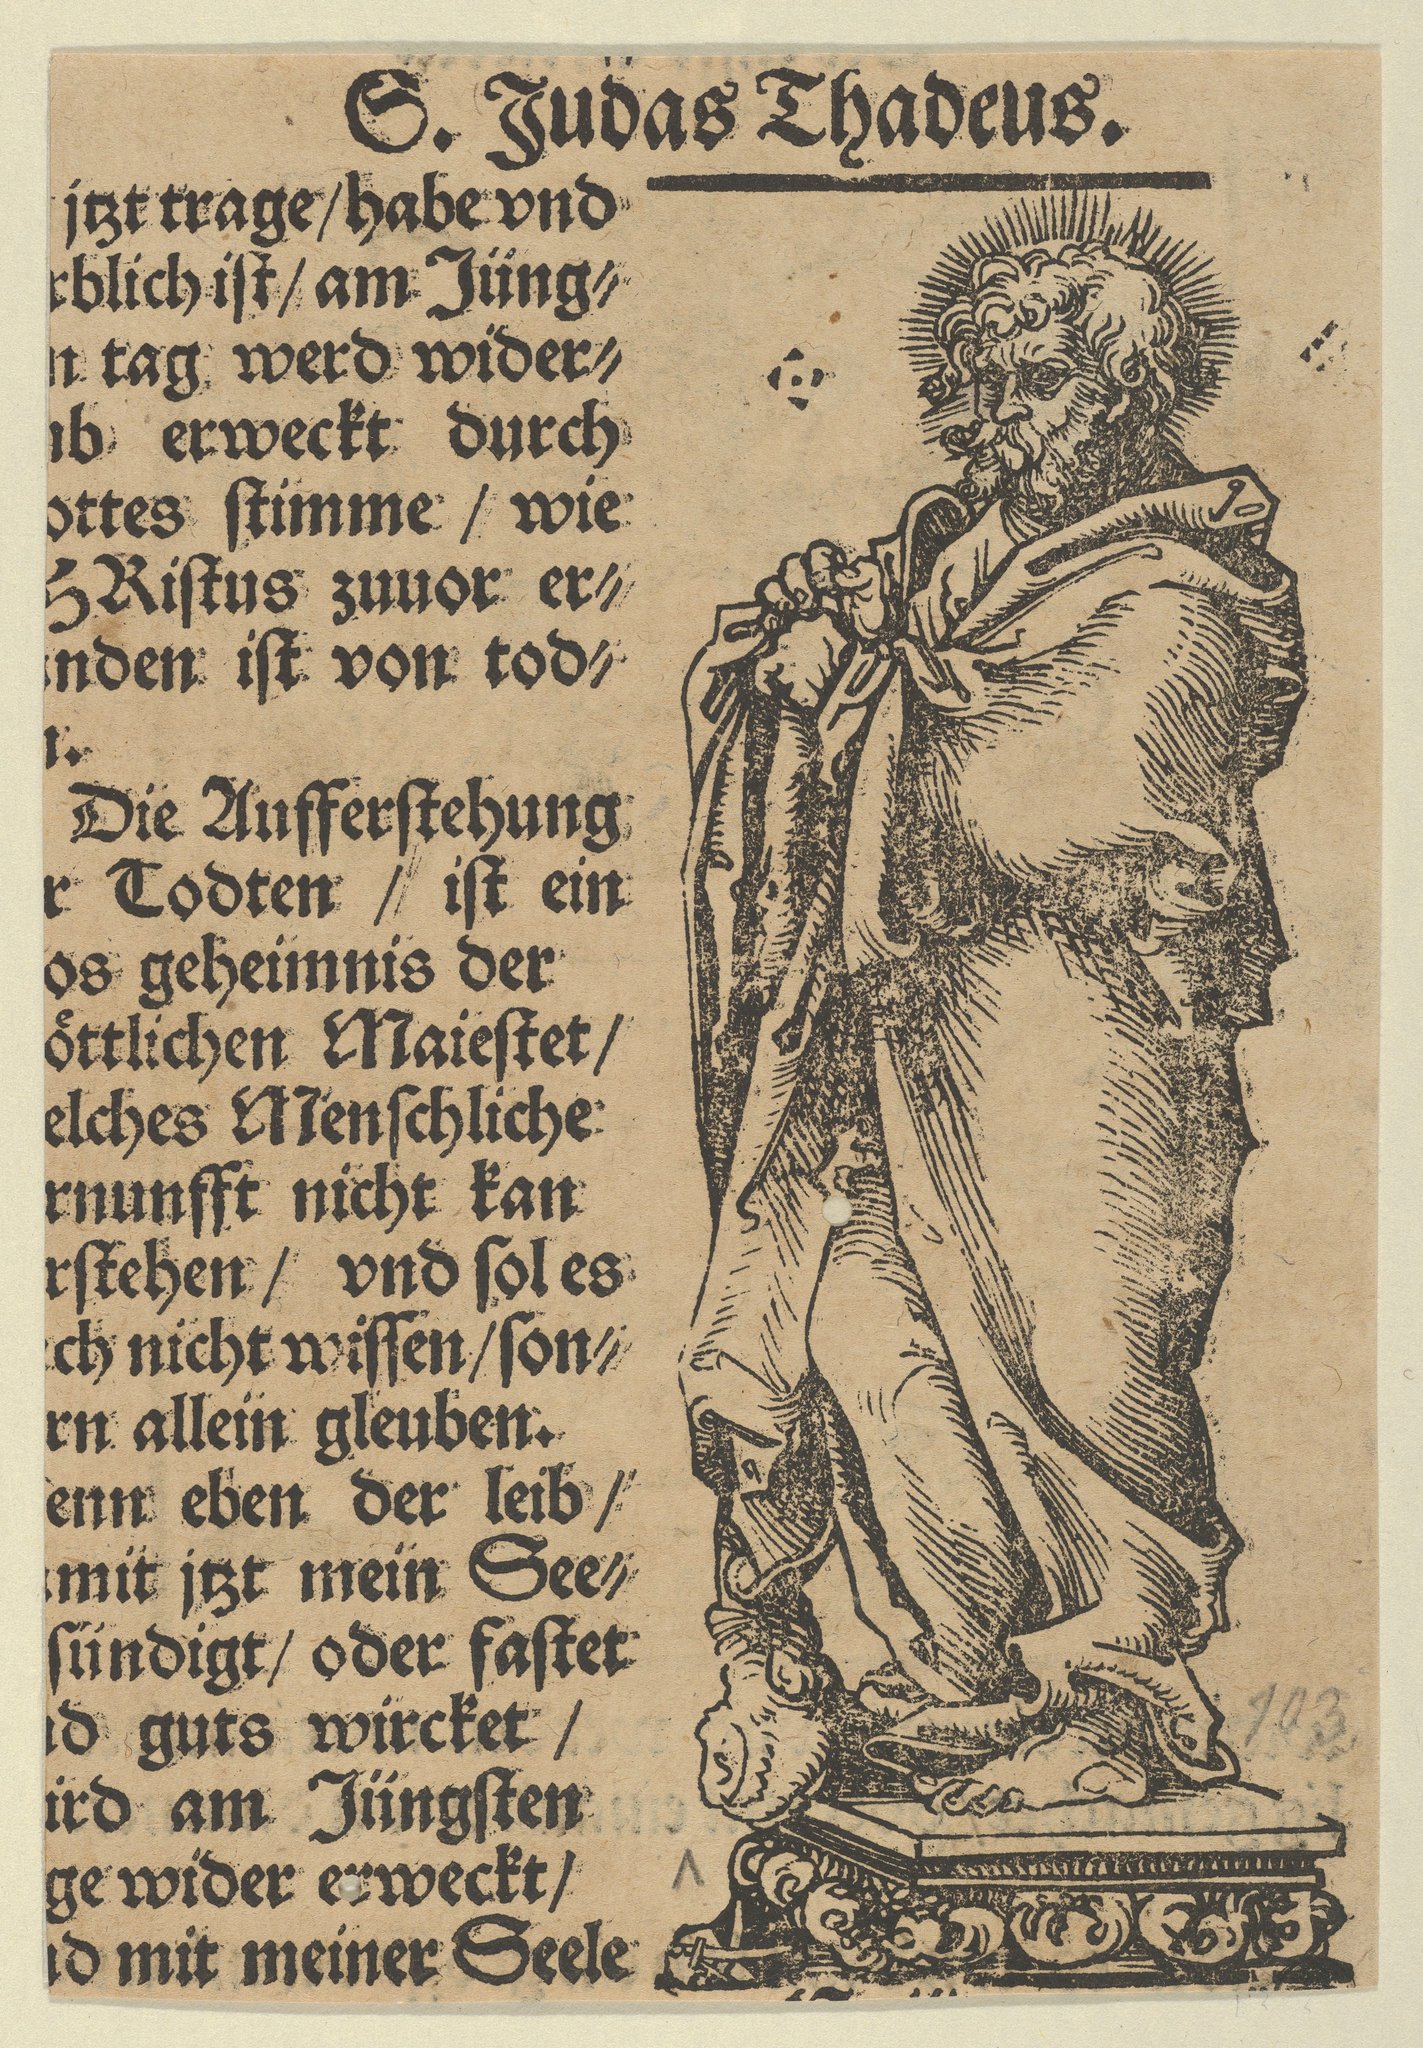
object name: print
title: Silver Statuette of St. Jude, from the "Wittenberg Reliquaries"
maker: lucas cranach the elder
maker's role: artist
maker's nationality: german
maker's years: 1472-1553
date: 1472-1553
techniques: woodcut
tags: saints